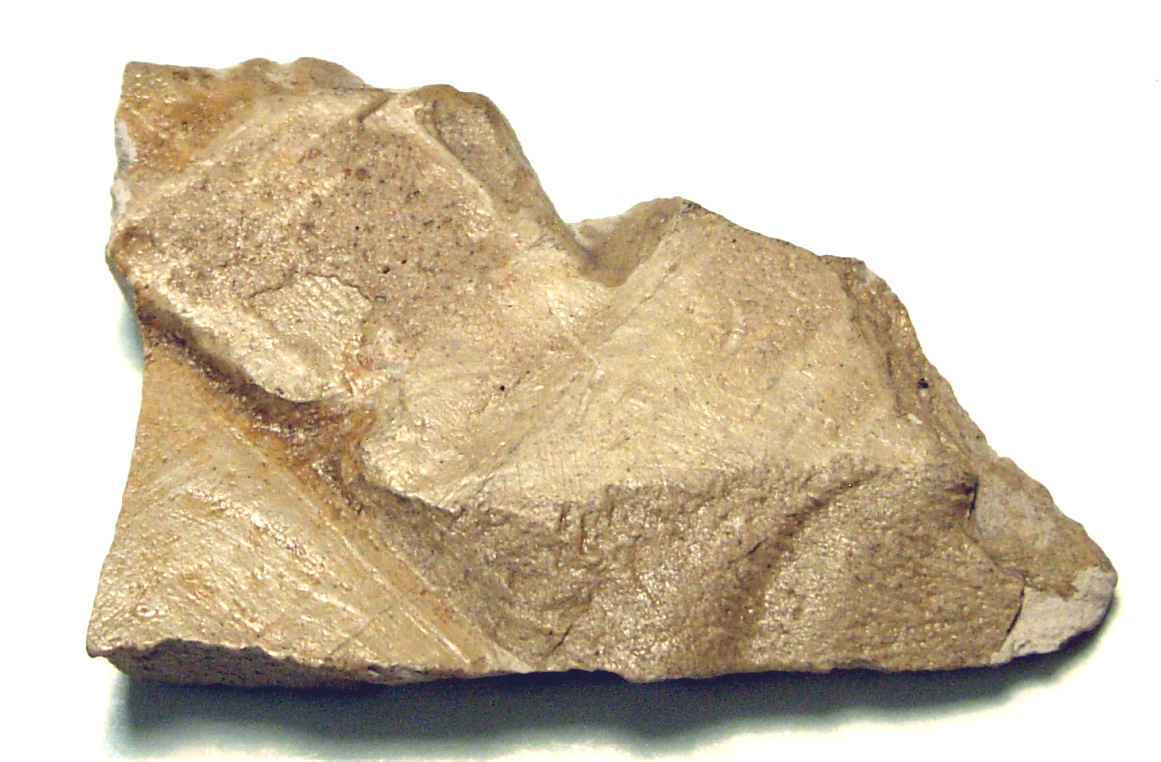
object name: relief, tomb of nespekashuty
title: Raised relief fragment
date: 664-610 BCE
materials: limestone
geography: egypt